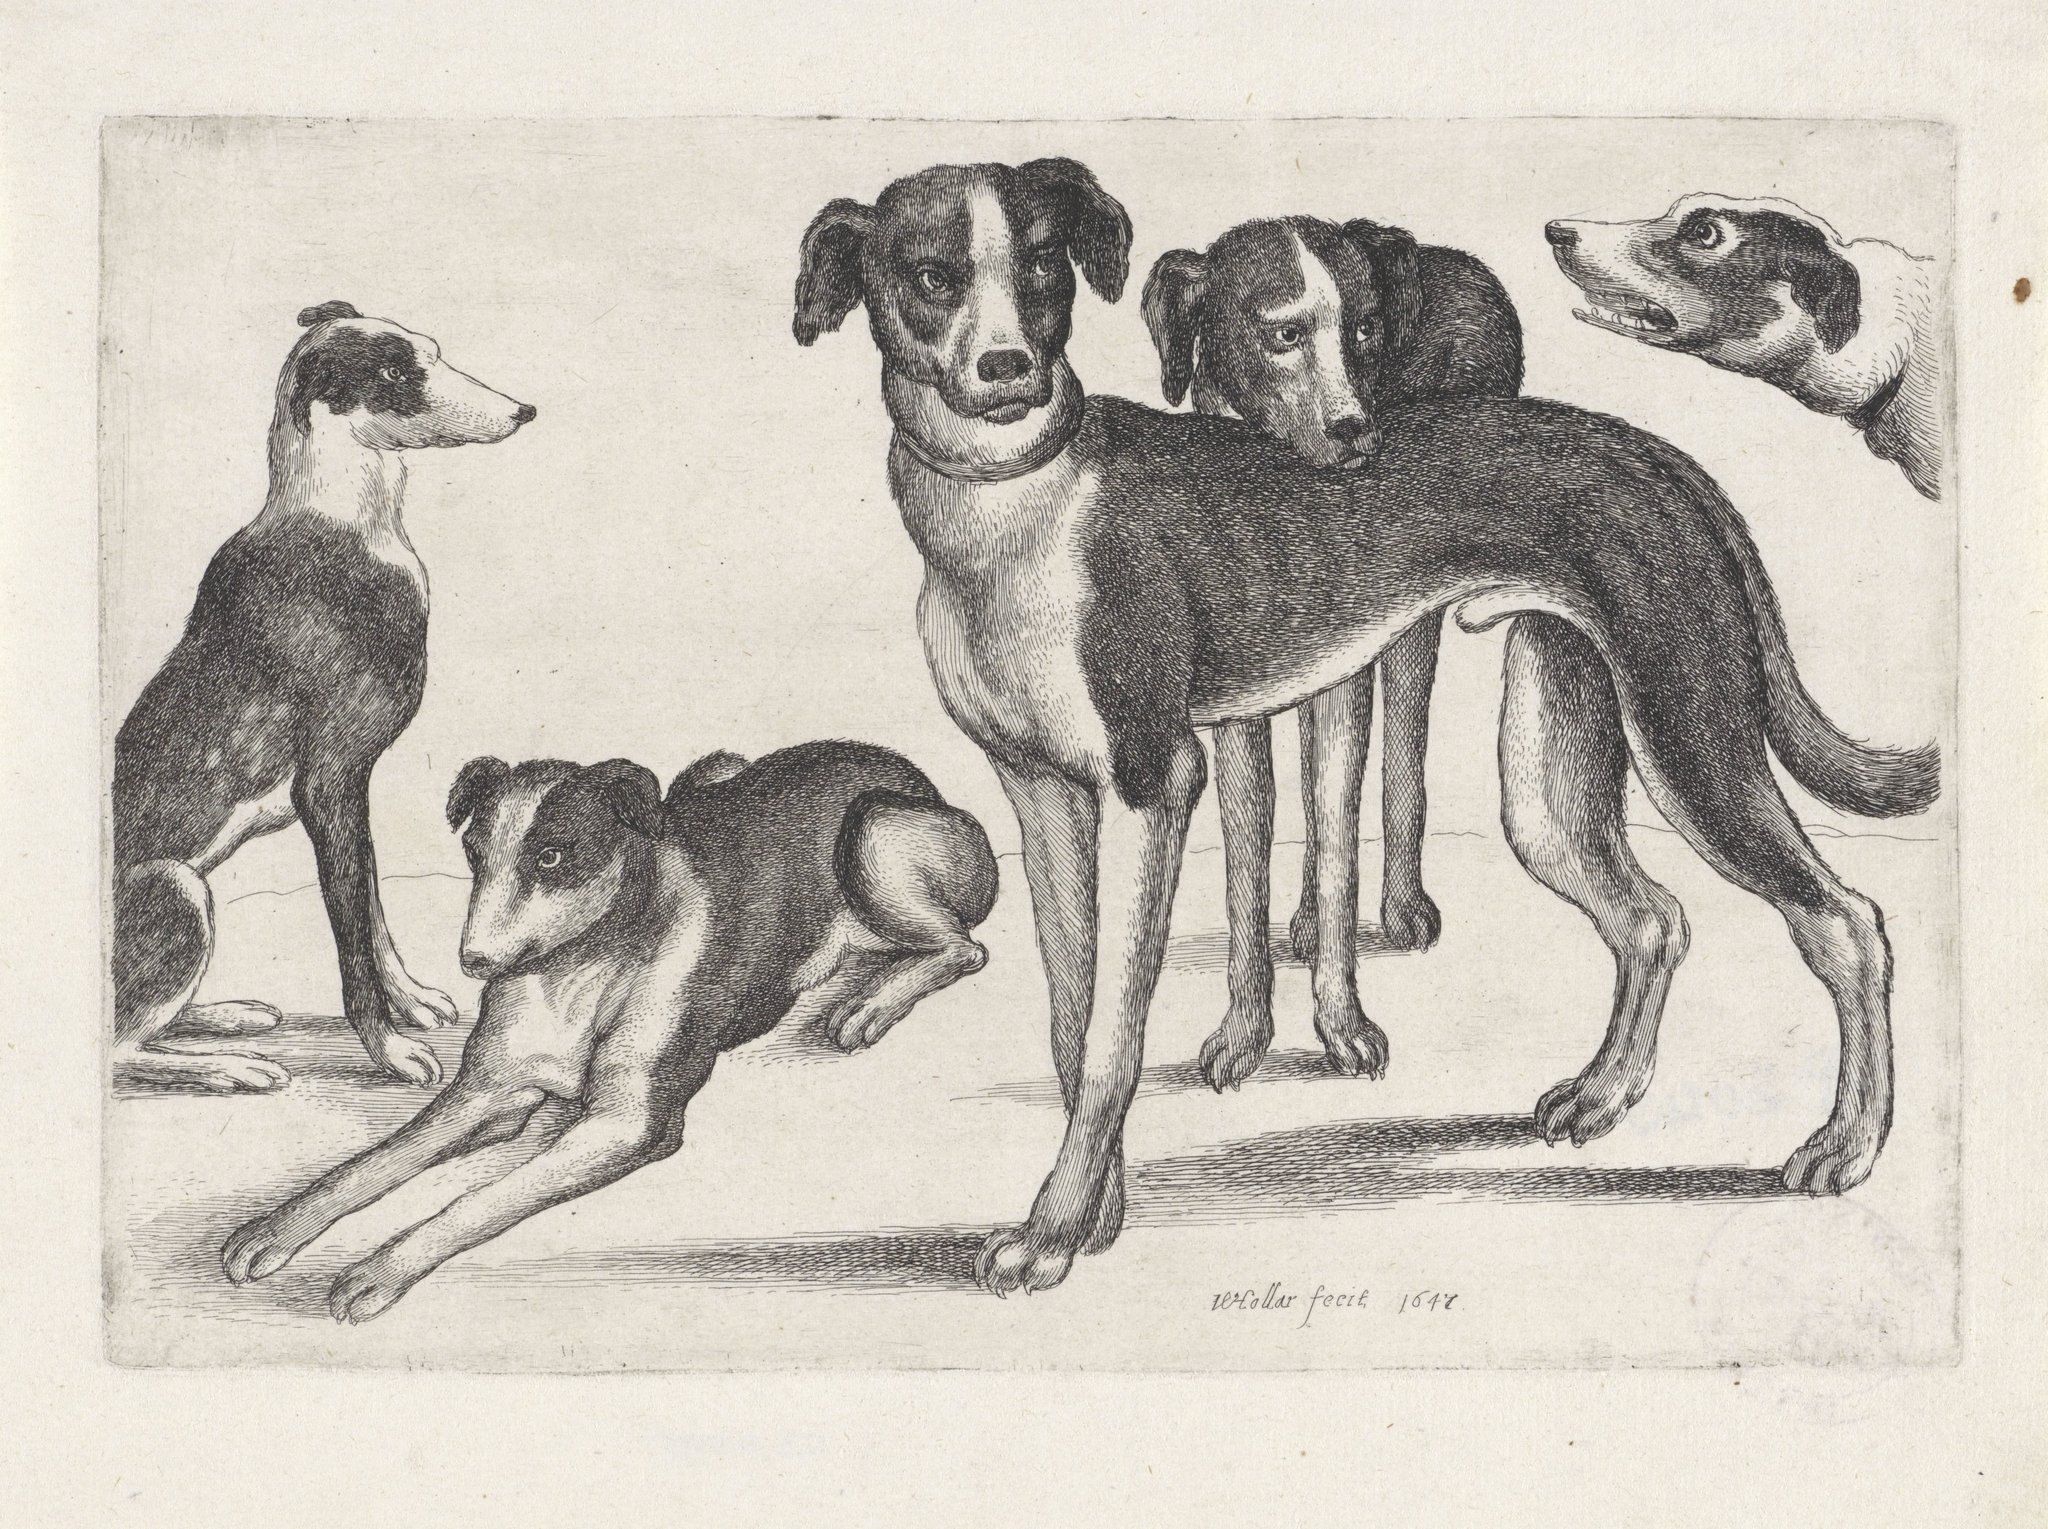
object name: print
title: Vijf jachthonden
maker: wenceslaus hollar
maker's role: draughtsman, print maker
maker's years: 1607-1677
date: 1647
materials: paper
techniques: etching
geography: antwerp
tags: hunting dogs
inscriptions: collector's mark: Lugt 240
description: Prent uit twintigdelige serie (incl. titelprent) met voorstellingen over de jacht: "Jacht, jachthonden en wild".